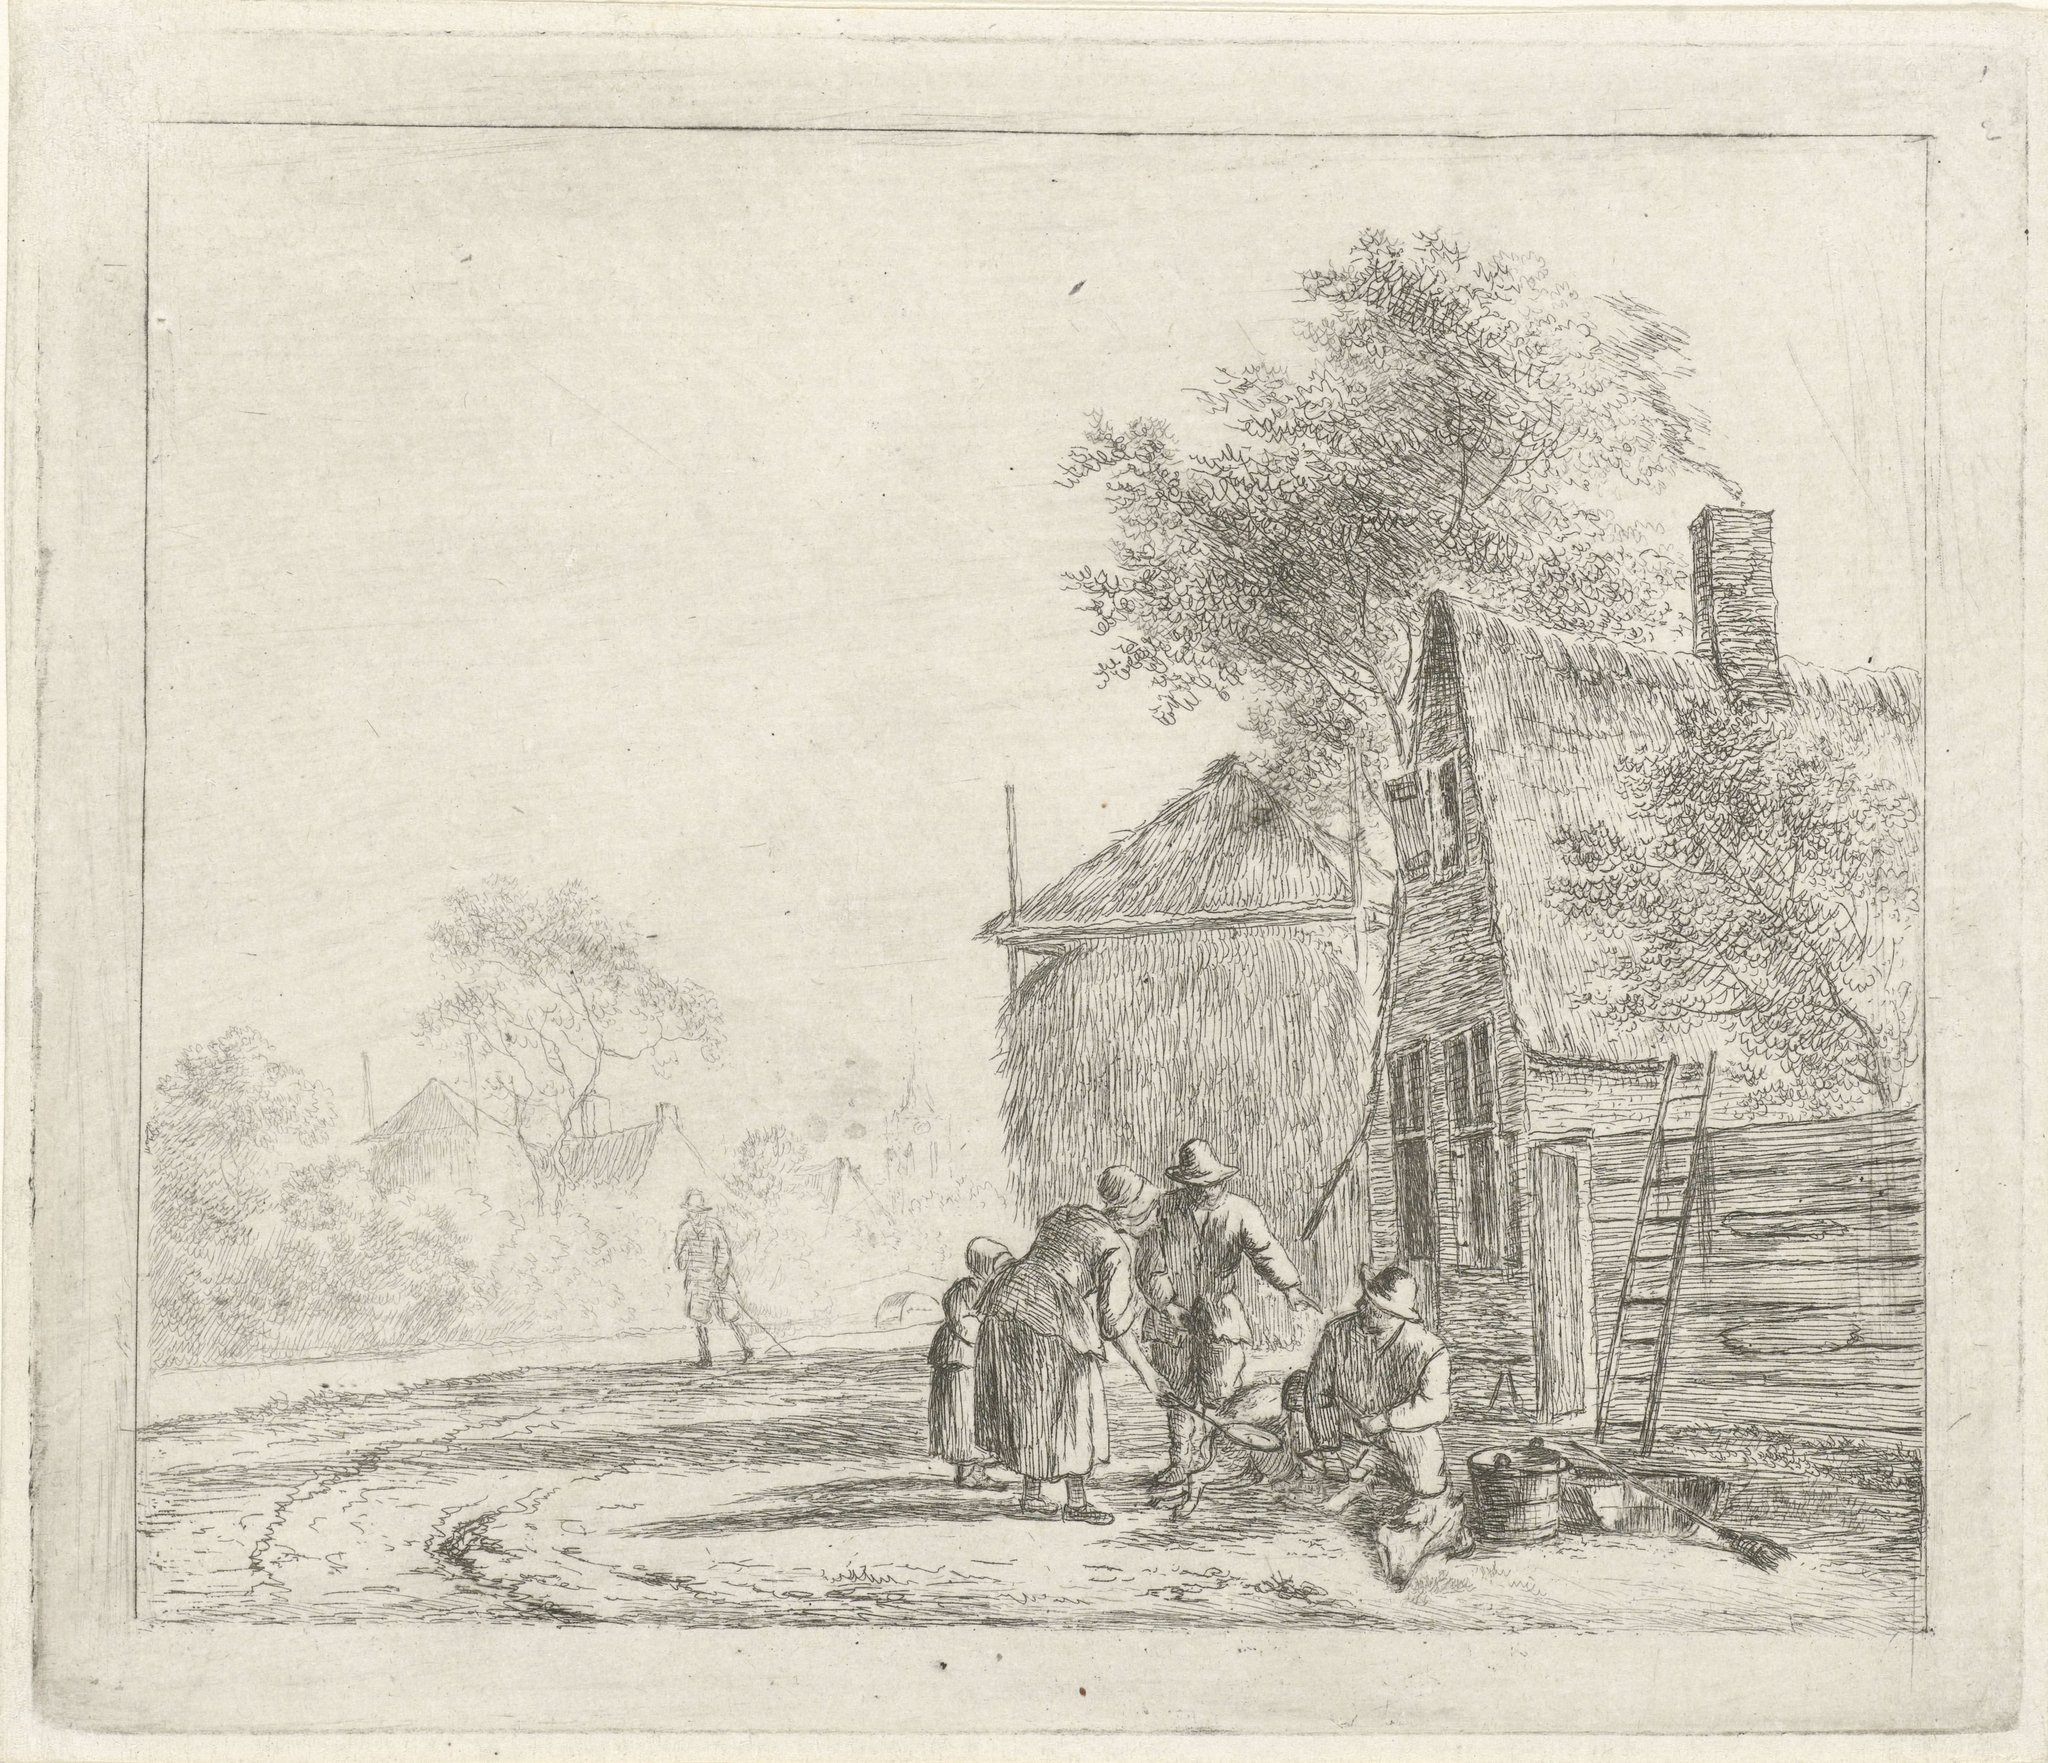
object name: print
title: De twaalf maanden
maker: johannes janson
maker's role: draughtsman, painter, print maker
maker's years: 1729-1784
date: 1783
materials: paper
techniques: etching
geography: leiden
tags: landscape symbolizing november, hay-stack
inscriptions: collector's mark: Lugt 2228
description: Landschap met rechts een boerderij en een hooischuur. Voor de boerderij een groep van twee vrouwen en twee mannen, van wie één een varken open snijdt. Links op een pad een wandelende man. Op de achtergrond een hooischuur en kerktoren. Vóór de lucht. Twaalfde prent uit een serie van dertien met maanden.